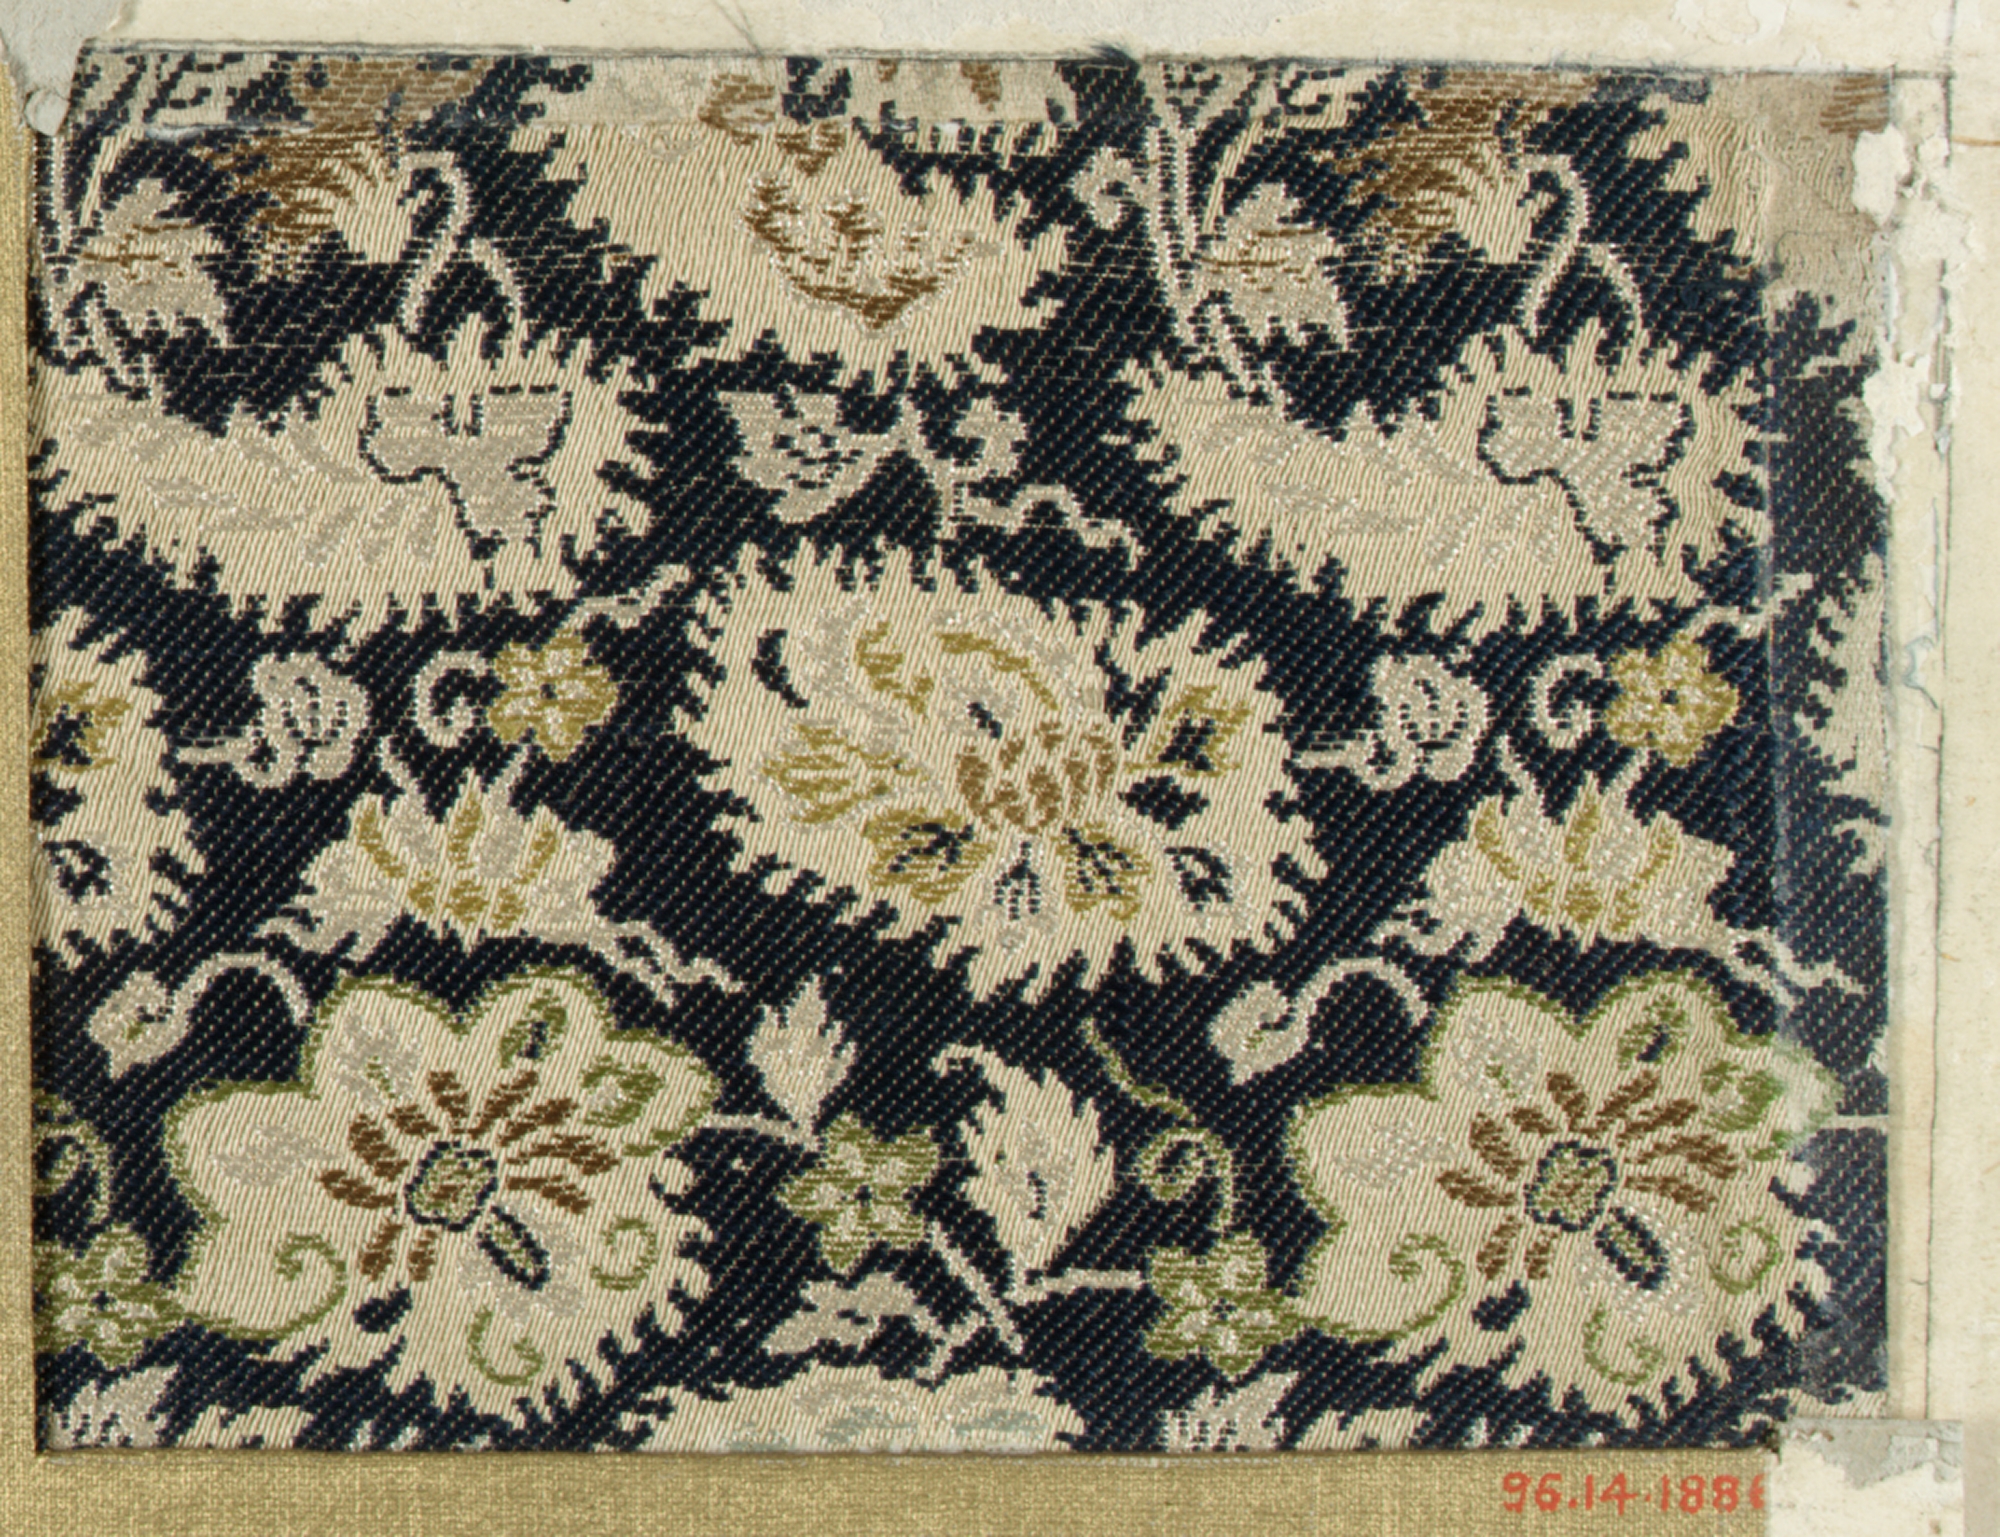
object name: piece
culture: japanese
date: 1701-1900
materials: silk